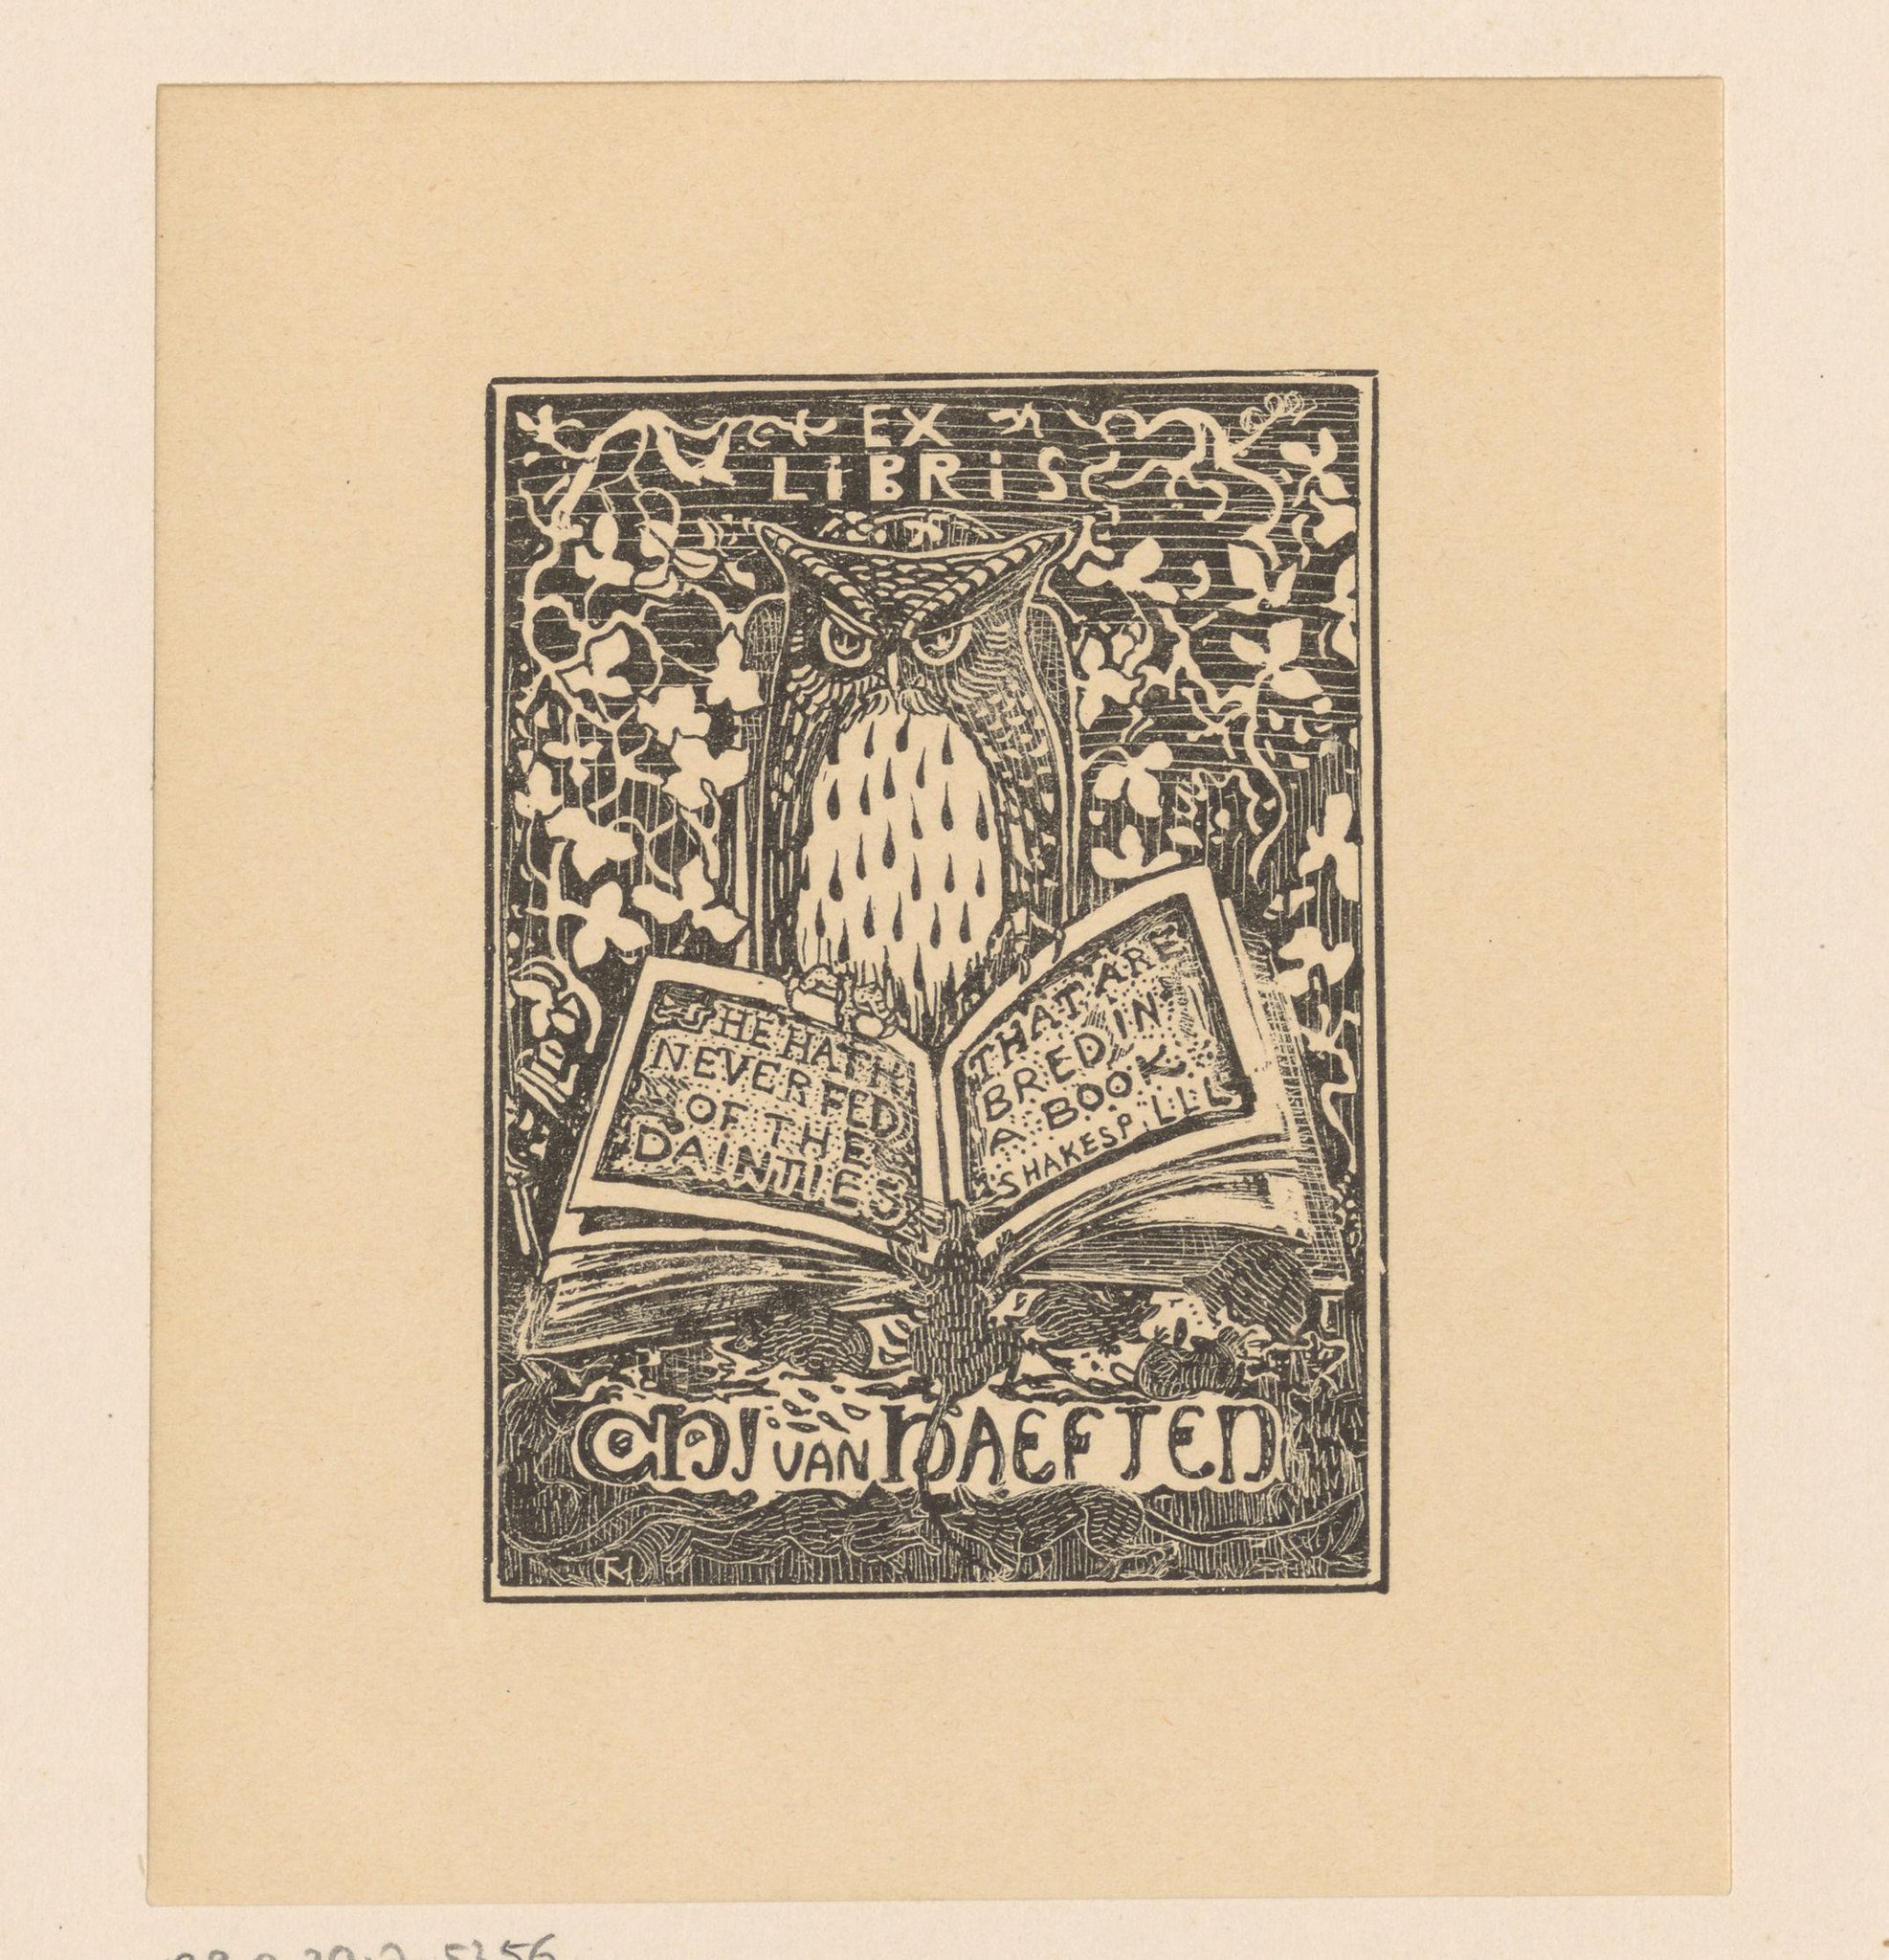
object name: bookplate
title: Ex libris van C.H.J. van Haeften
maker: theo van hoytema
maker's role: draughtsman, painter, print maker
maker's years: 1863-1917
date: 1894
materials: paper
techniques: lithograph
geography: netherlands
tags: book, owls